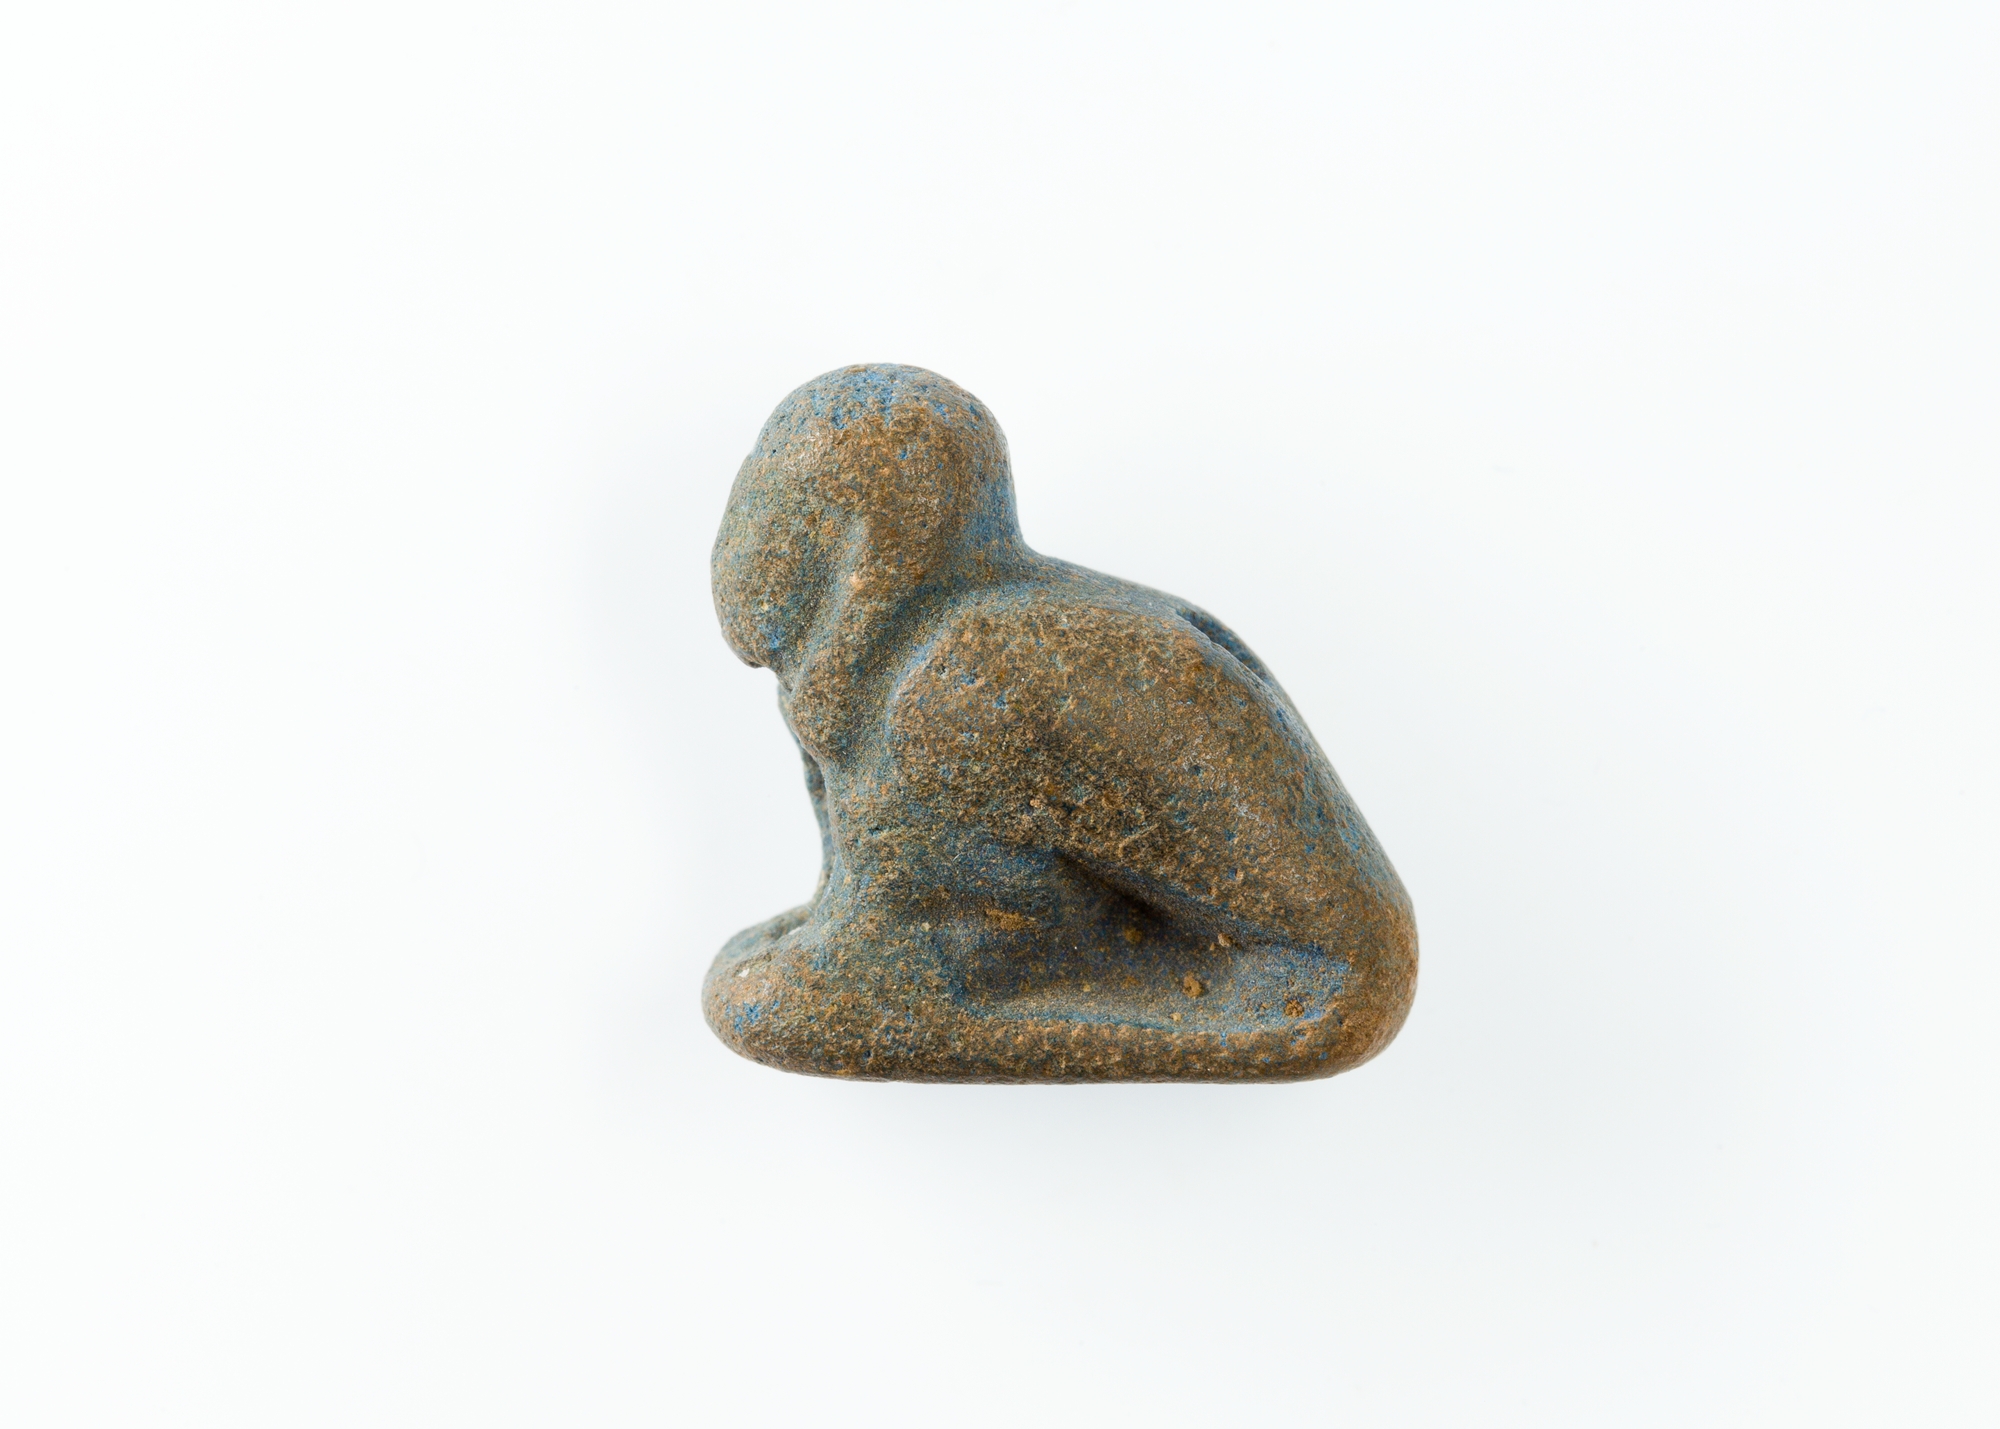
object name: amulet, ba bird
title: Animal amulet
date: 1850-1640 BCE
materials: faience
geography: egypt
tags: animals